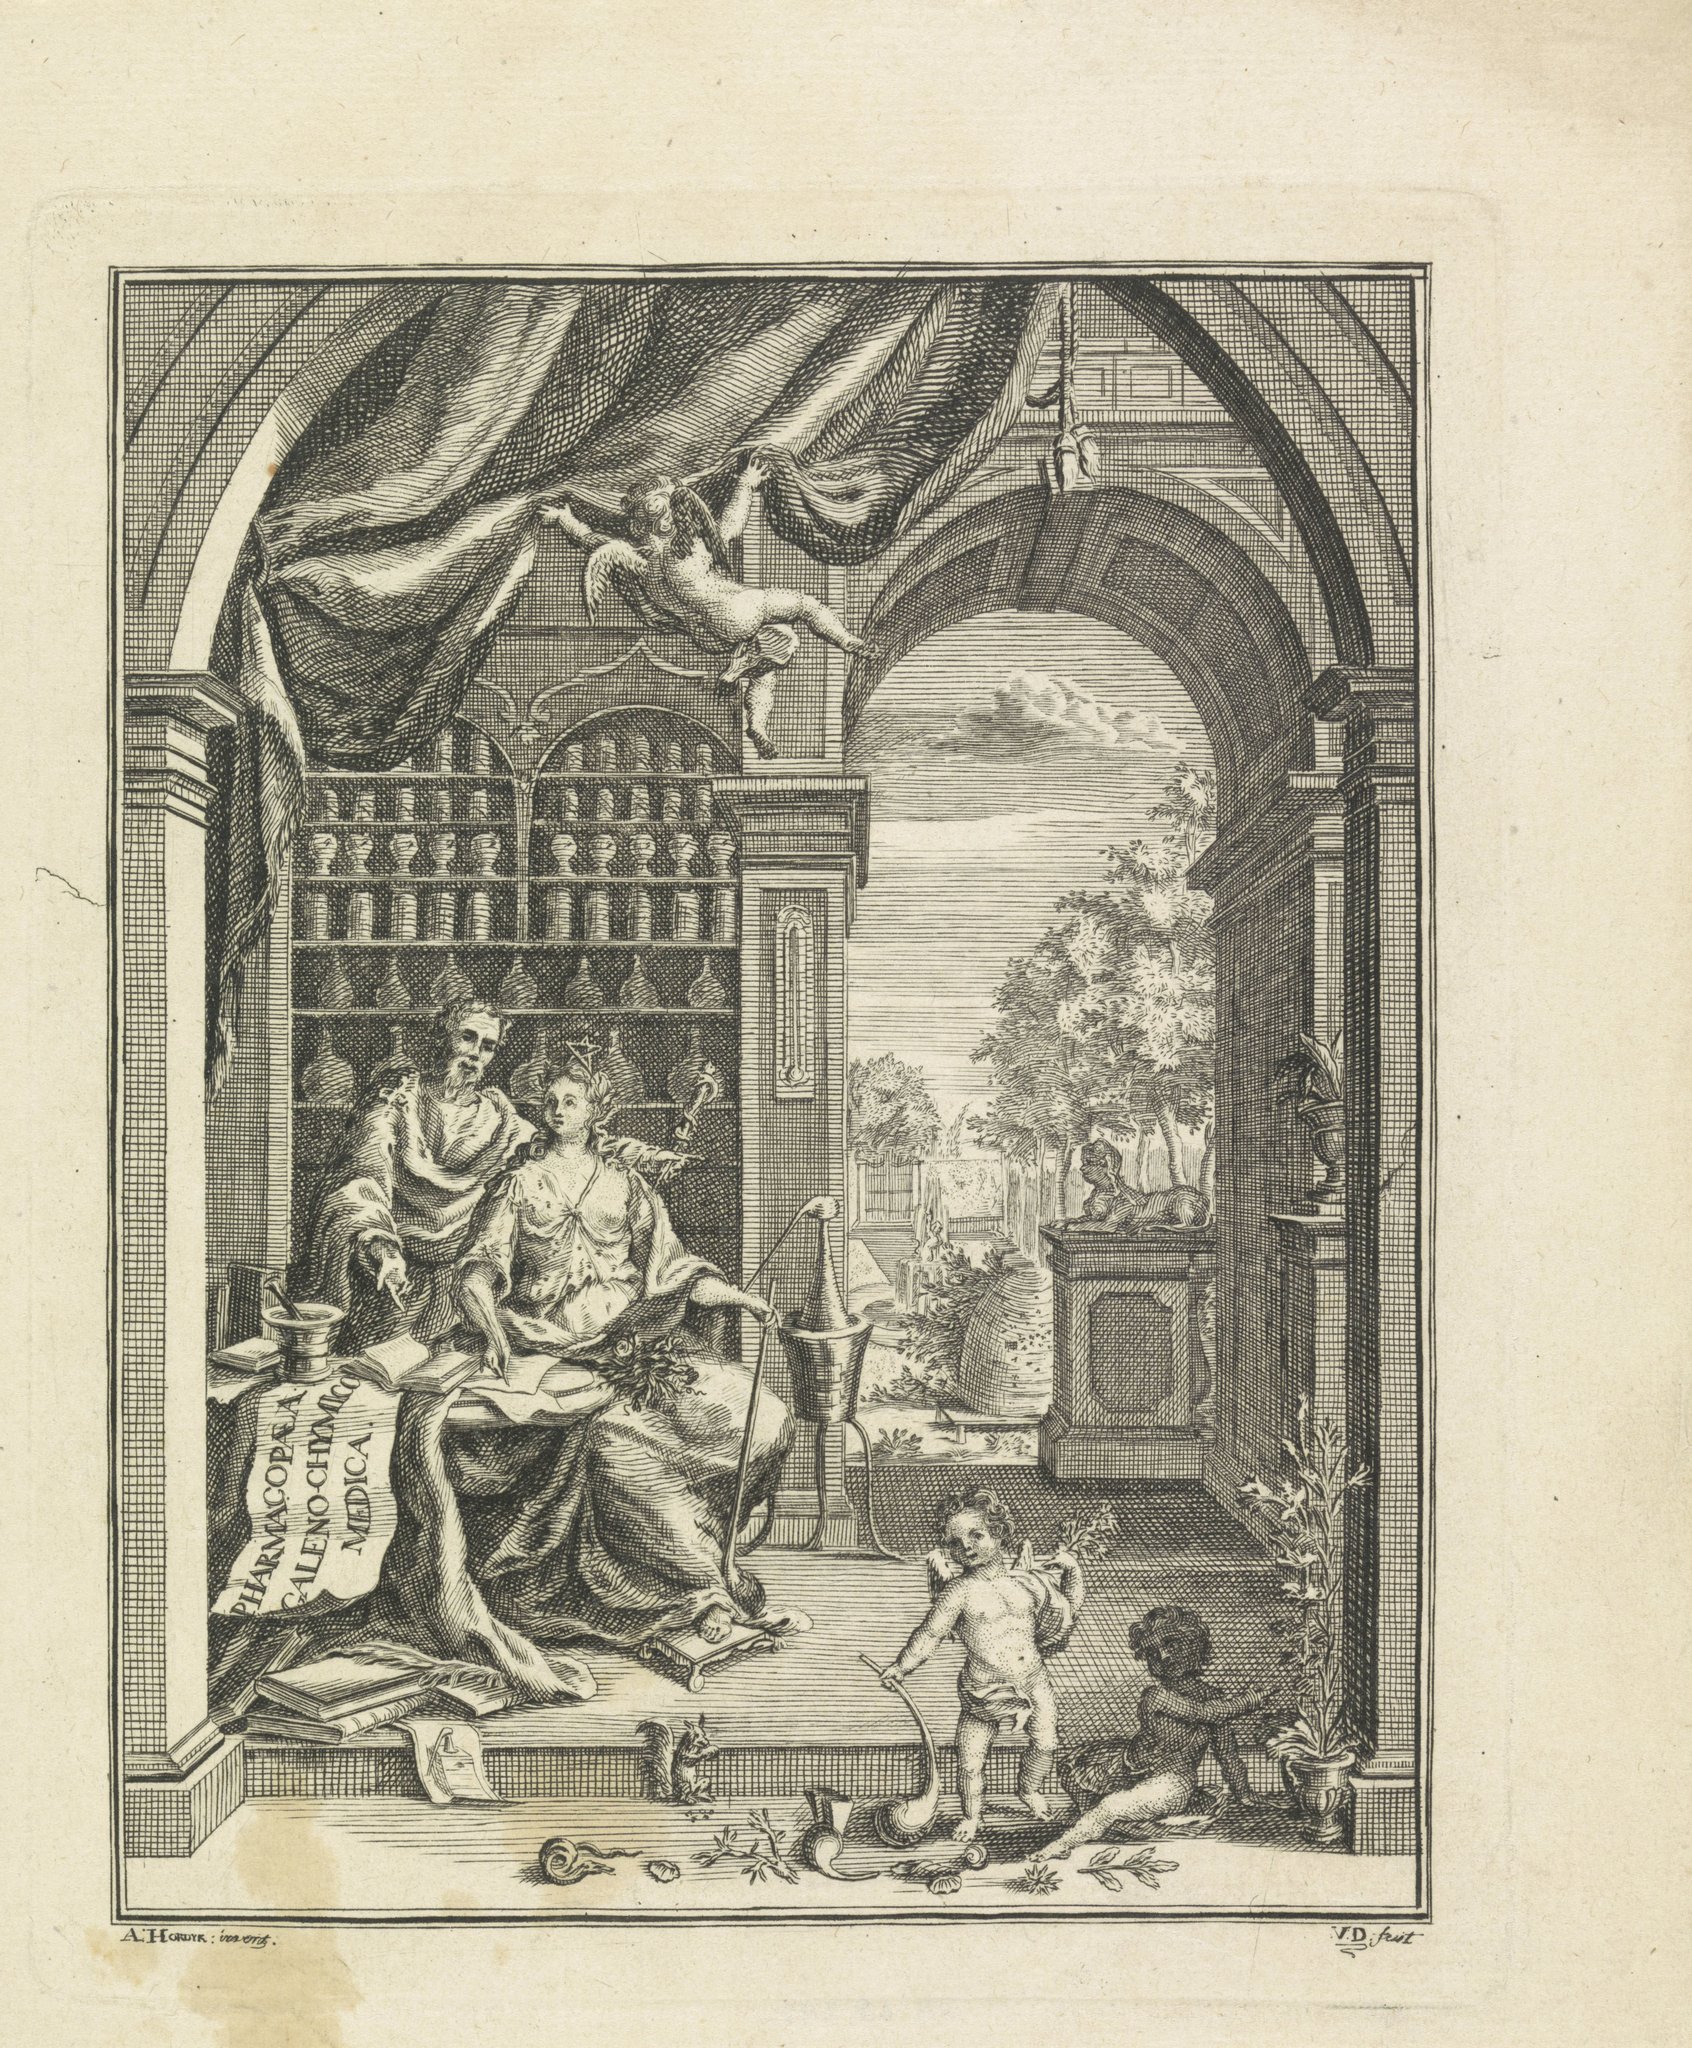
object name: titelblad, titelpagina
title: Apotheek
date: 1700-1800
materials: paper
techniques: etching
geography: netherlands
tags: pharmacy, pharmaceutics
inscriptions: collector's mark: Lugt 2228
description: Prent mogelijk gebuikt als titelpagina in een avn de edities van: Elzevier, Kornelis. Lexicon galeno-chymico-pharmaceuticum, of Apothekers woordenboek. Amsterdam, 1755.